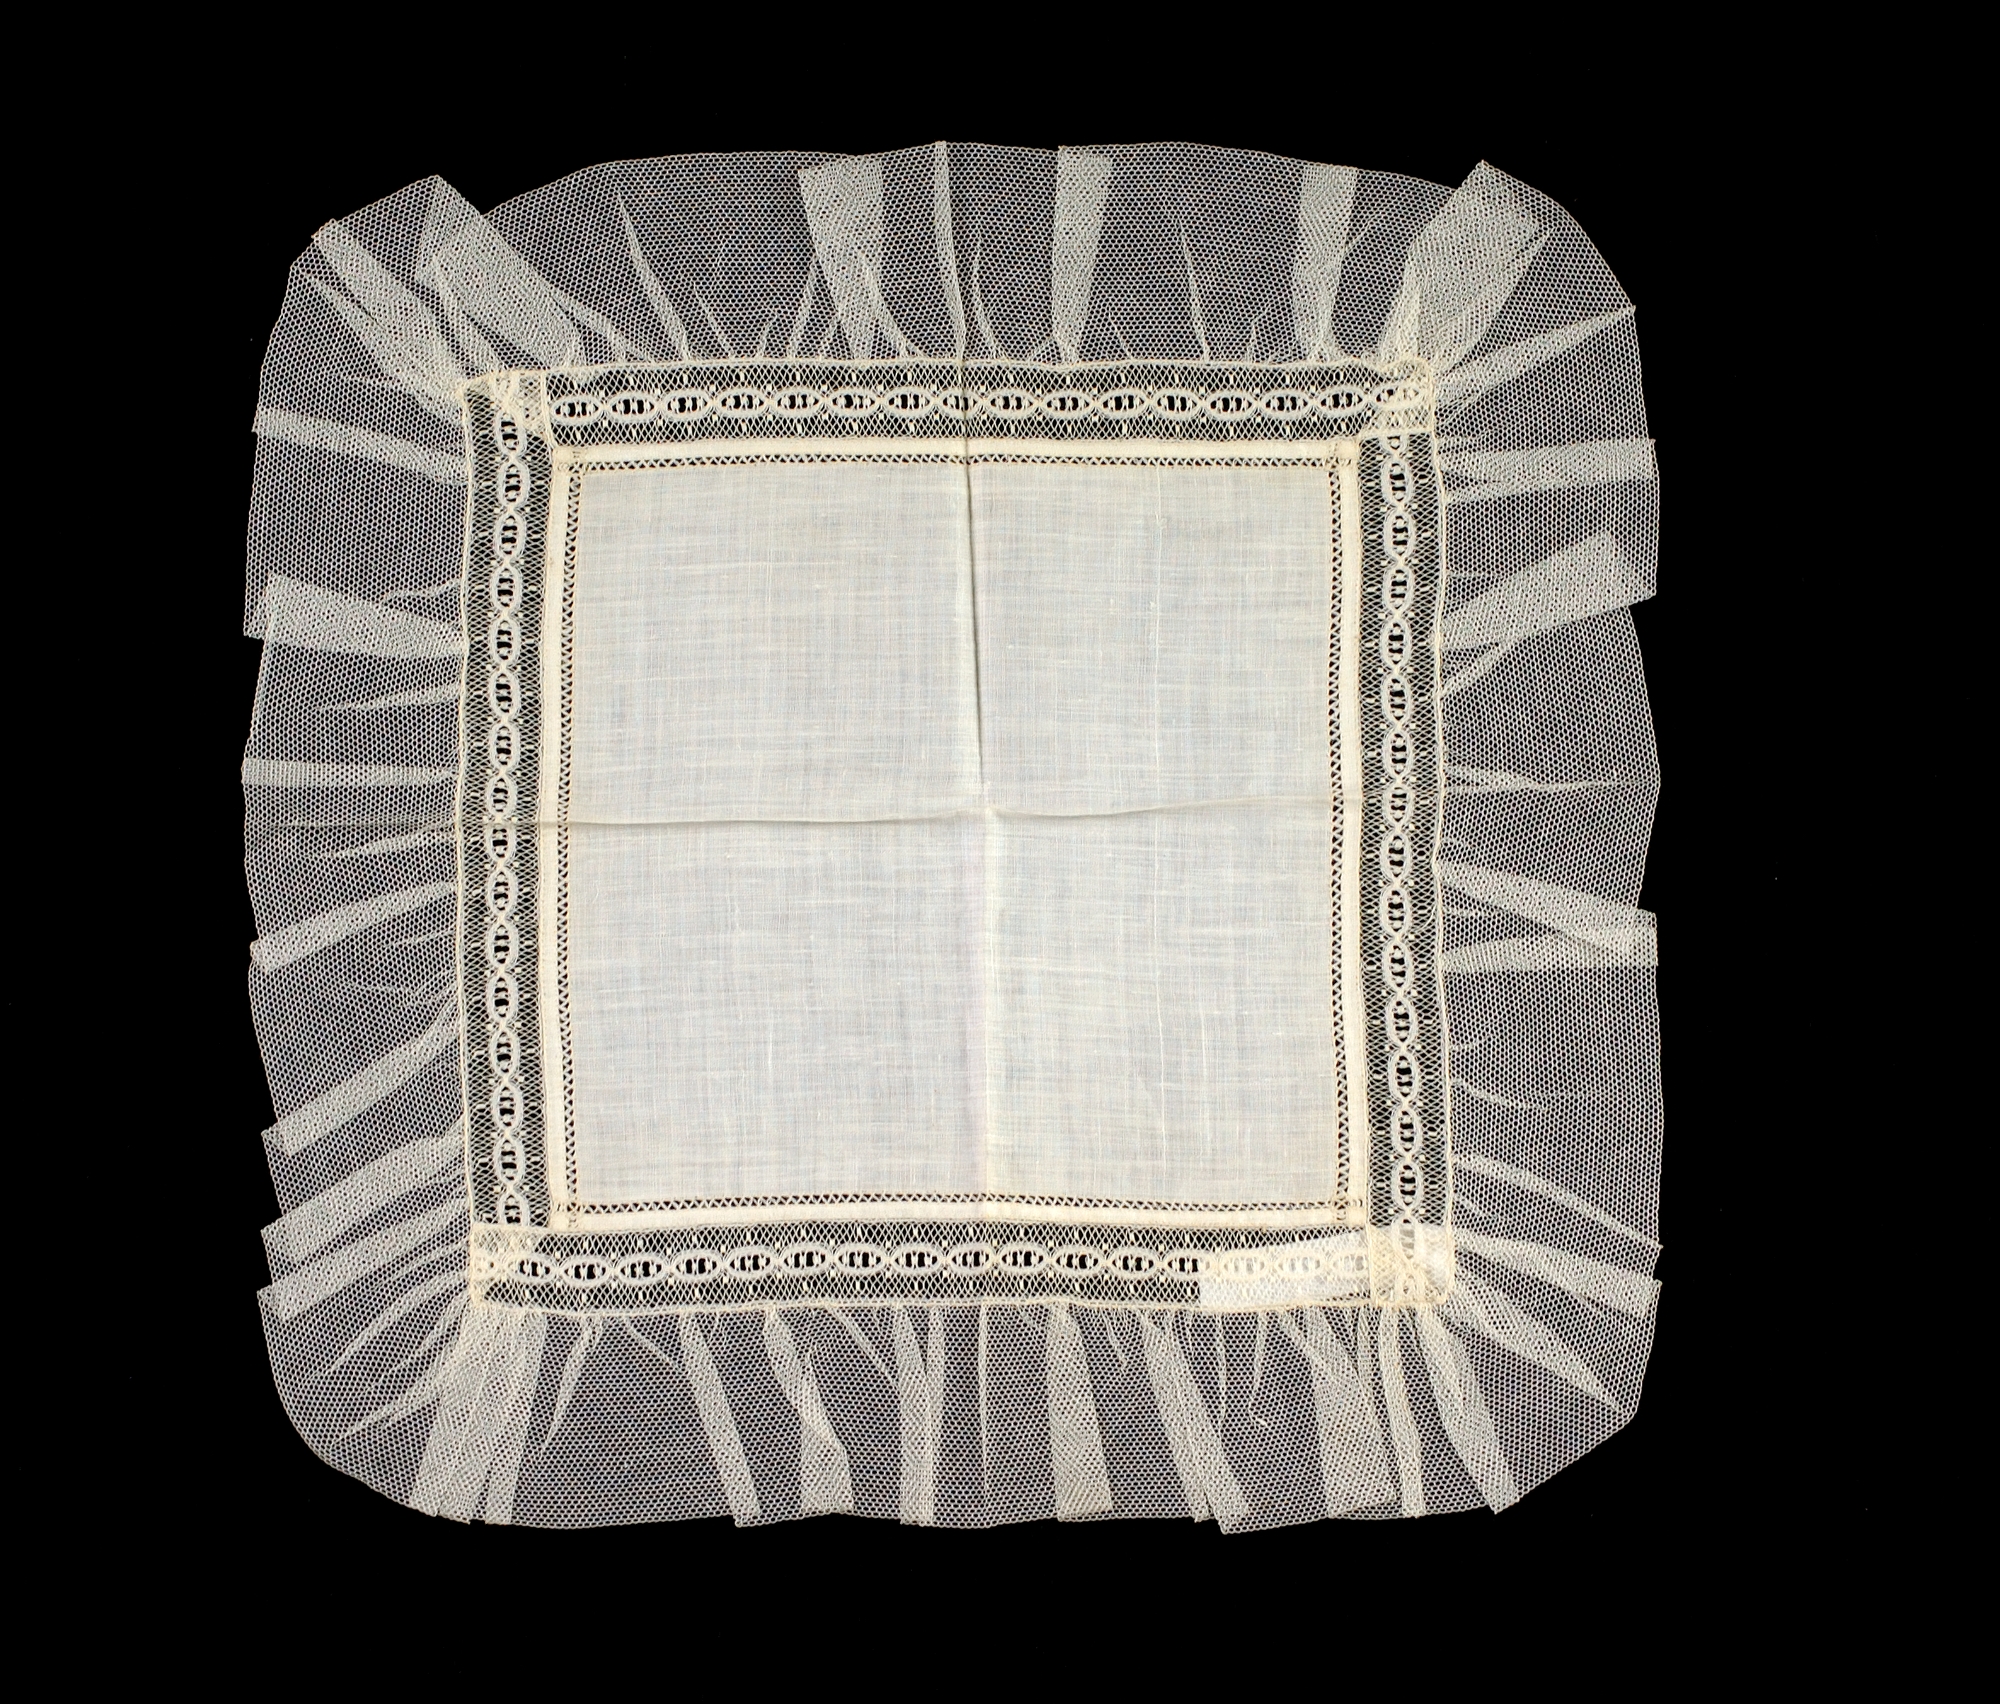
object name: handkerchief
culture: american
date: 1826-1850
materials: cotton